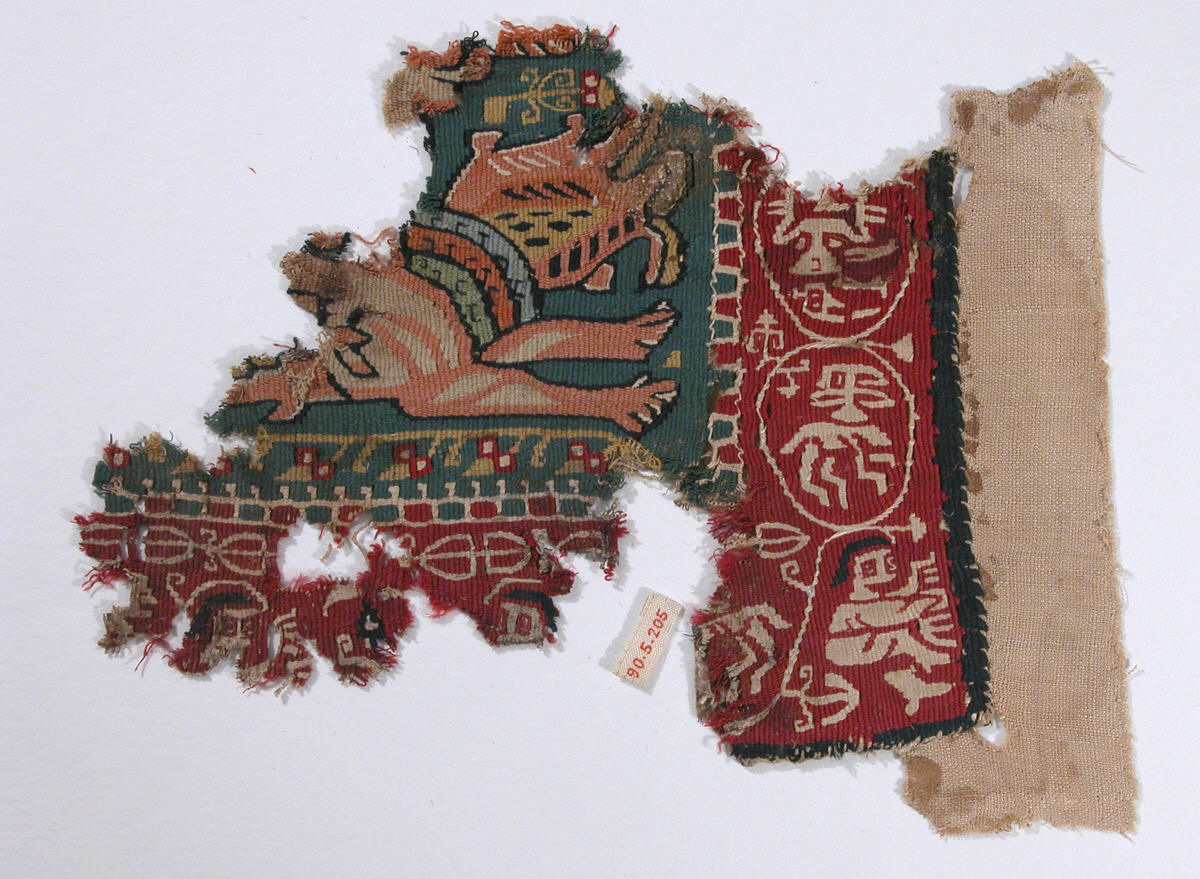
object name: textile fragment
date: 401-600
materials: linen, wool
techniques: weave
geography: egypt